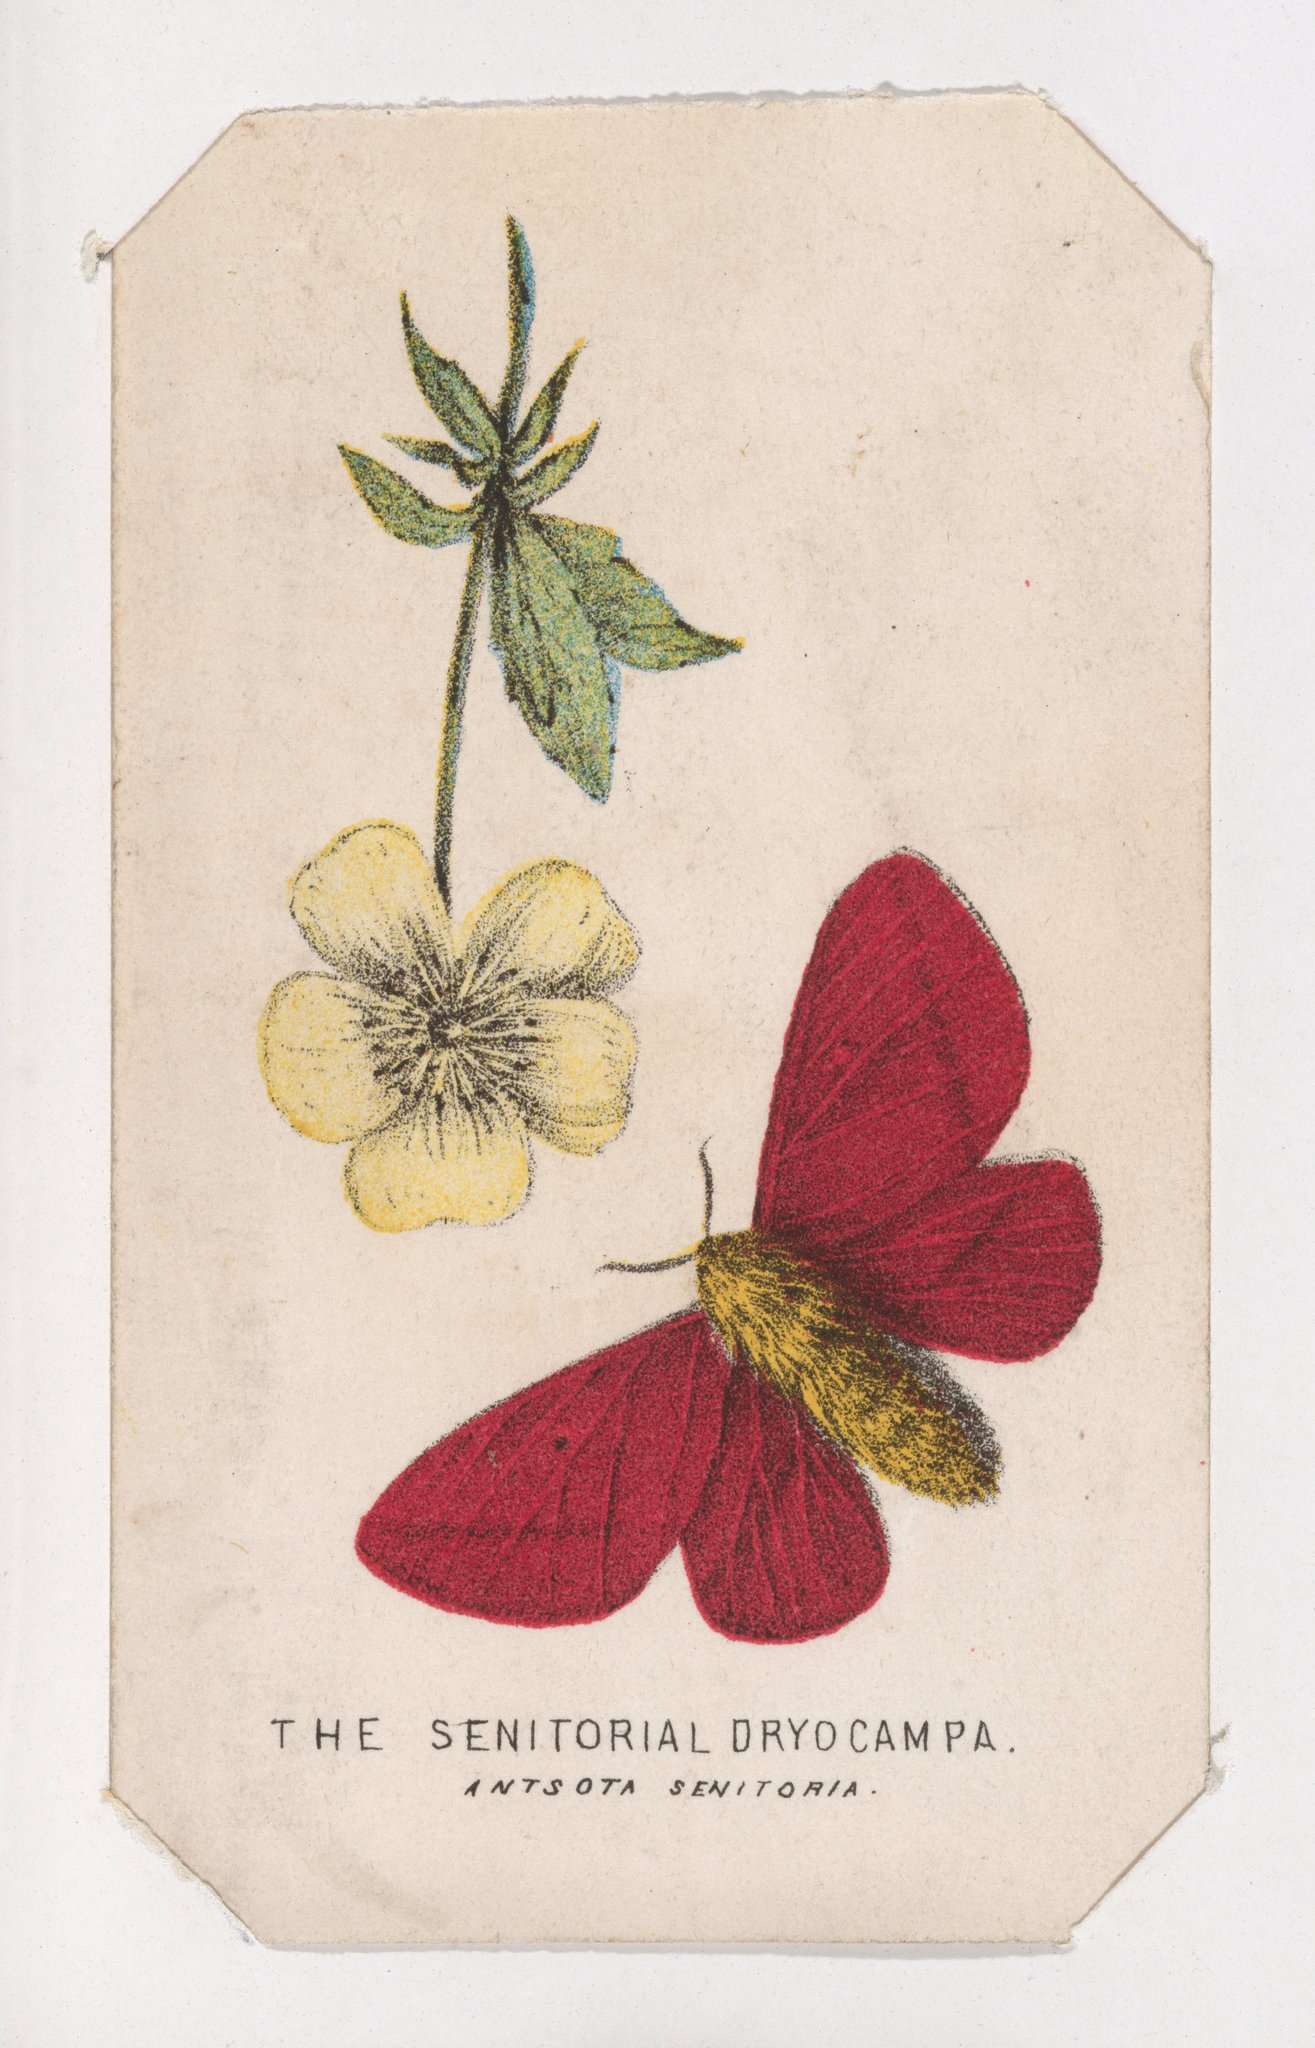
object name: album card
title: The Senitorial Dryocampa moth card from the "Butterflies and Moths of America" series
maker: louis prang & co.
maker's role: publisher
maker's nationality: american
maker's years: 1800-1950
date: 1862-1869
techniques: lithograph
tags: butterflies